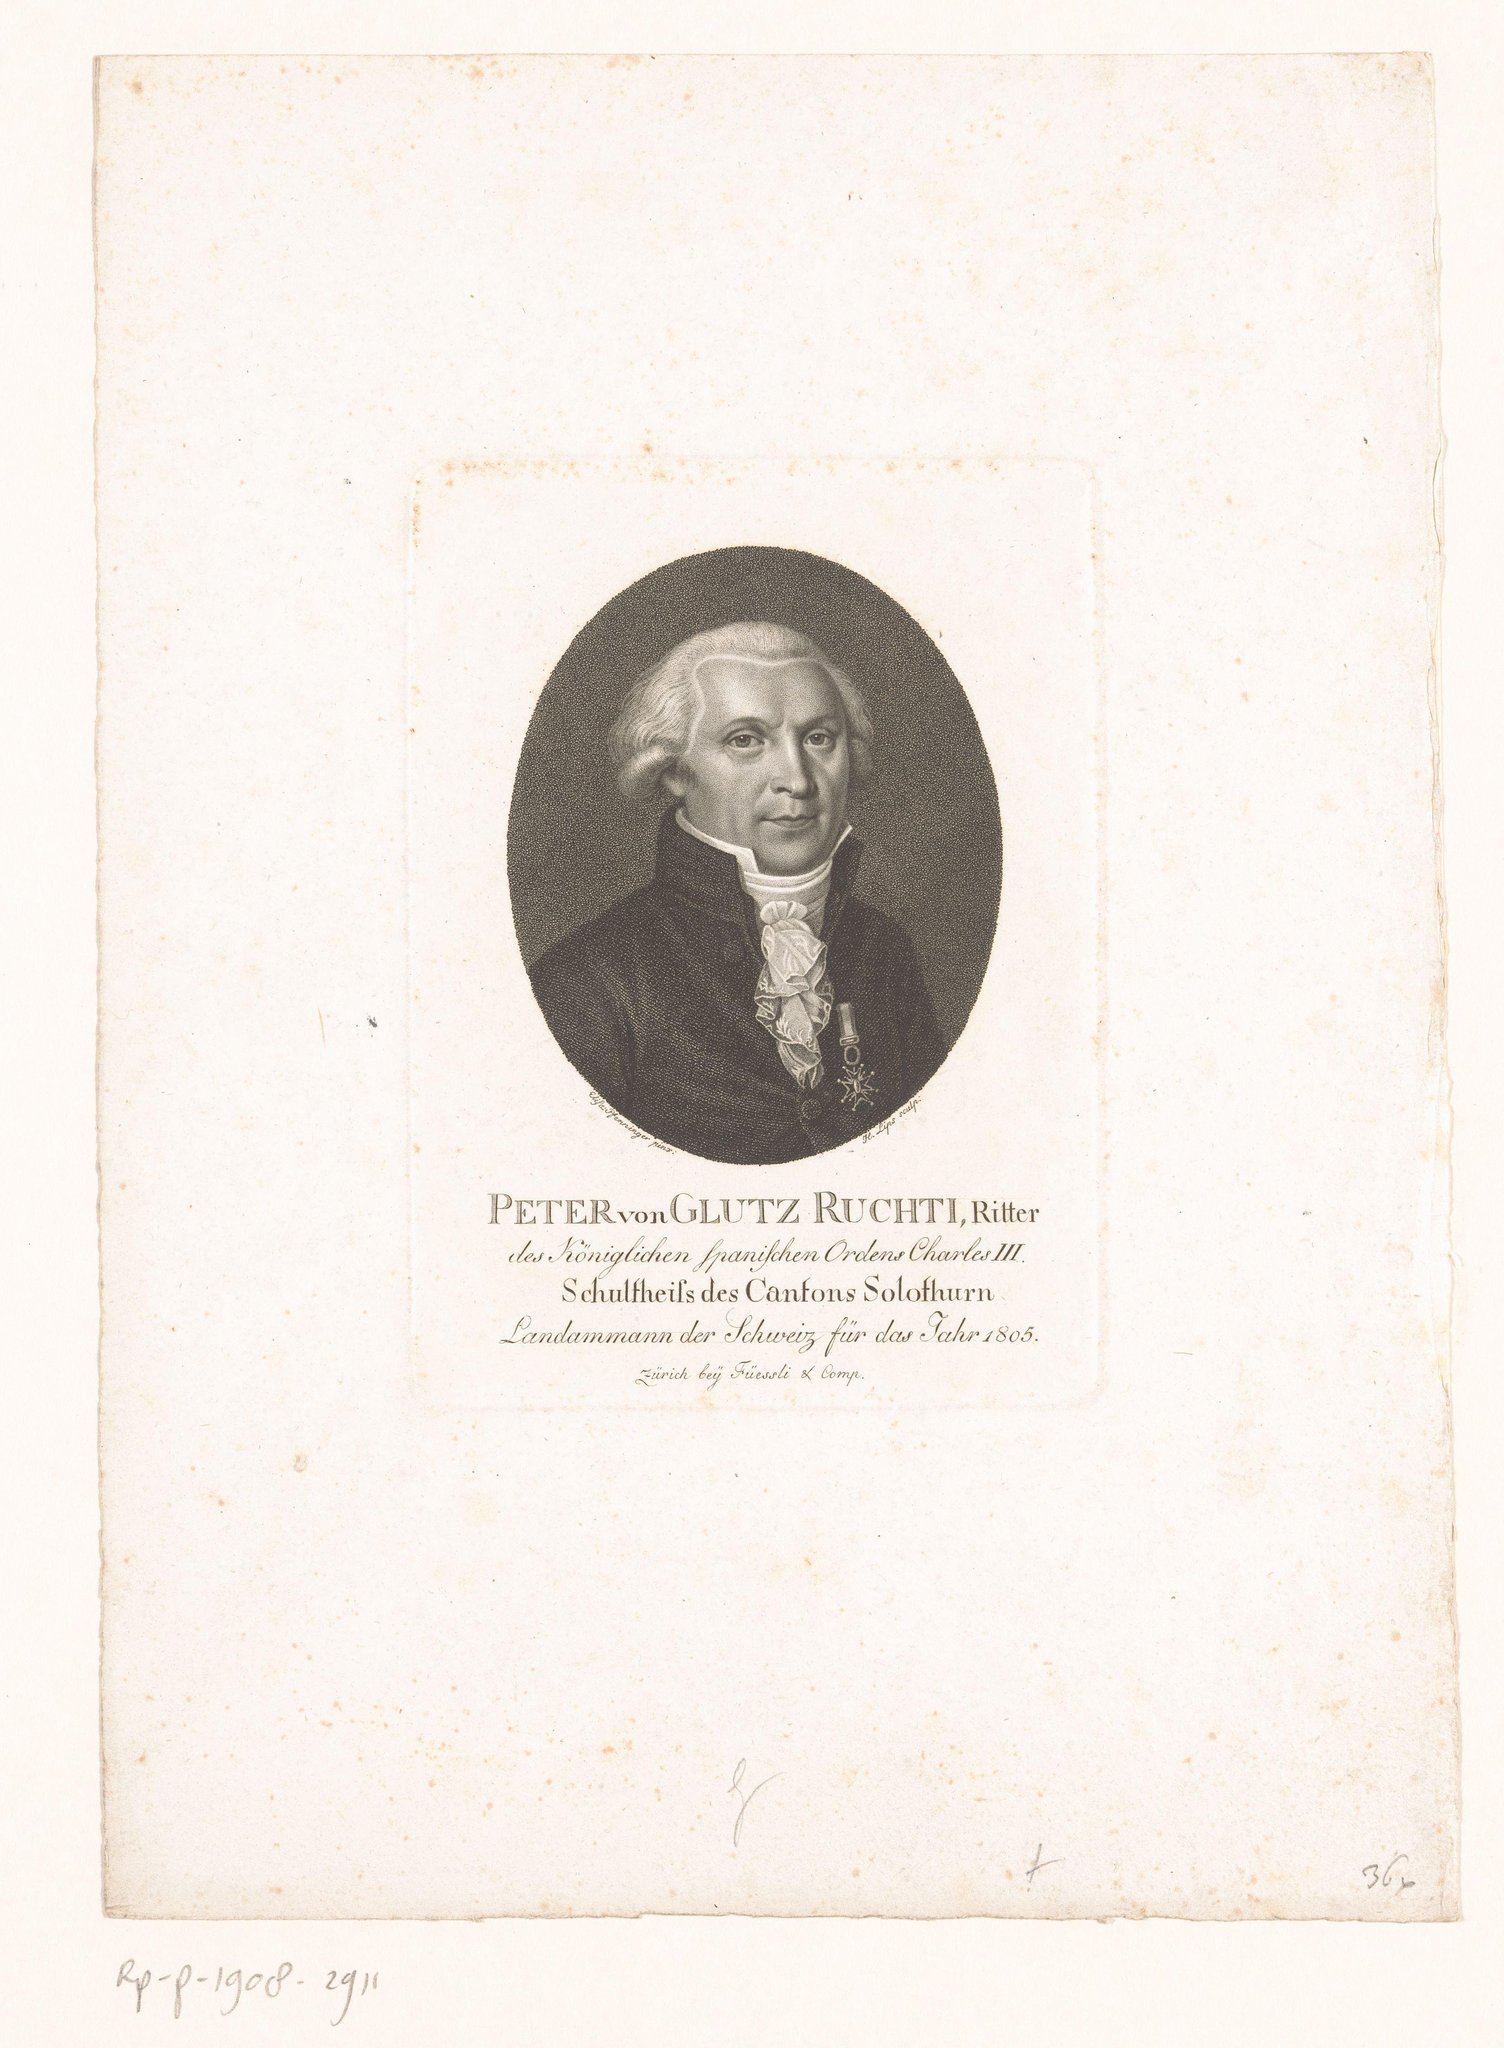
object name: print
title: Portret van Peter Josef Glutz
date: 1805-1817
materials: paper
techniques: engraving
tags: historical persons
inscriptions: collector's mark: Lugt 2228